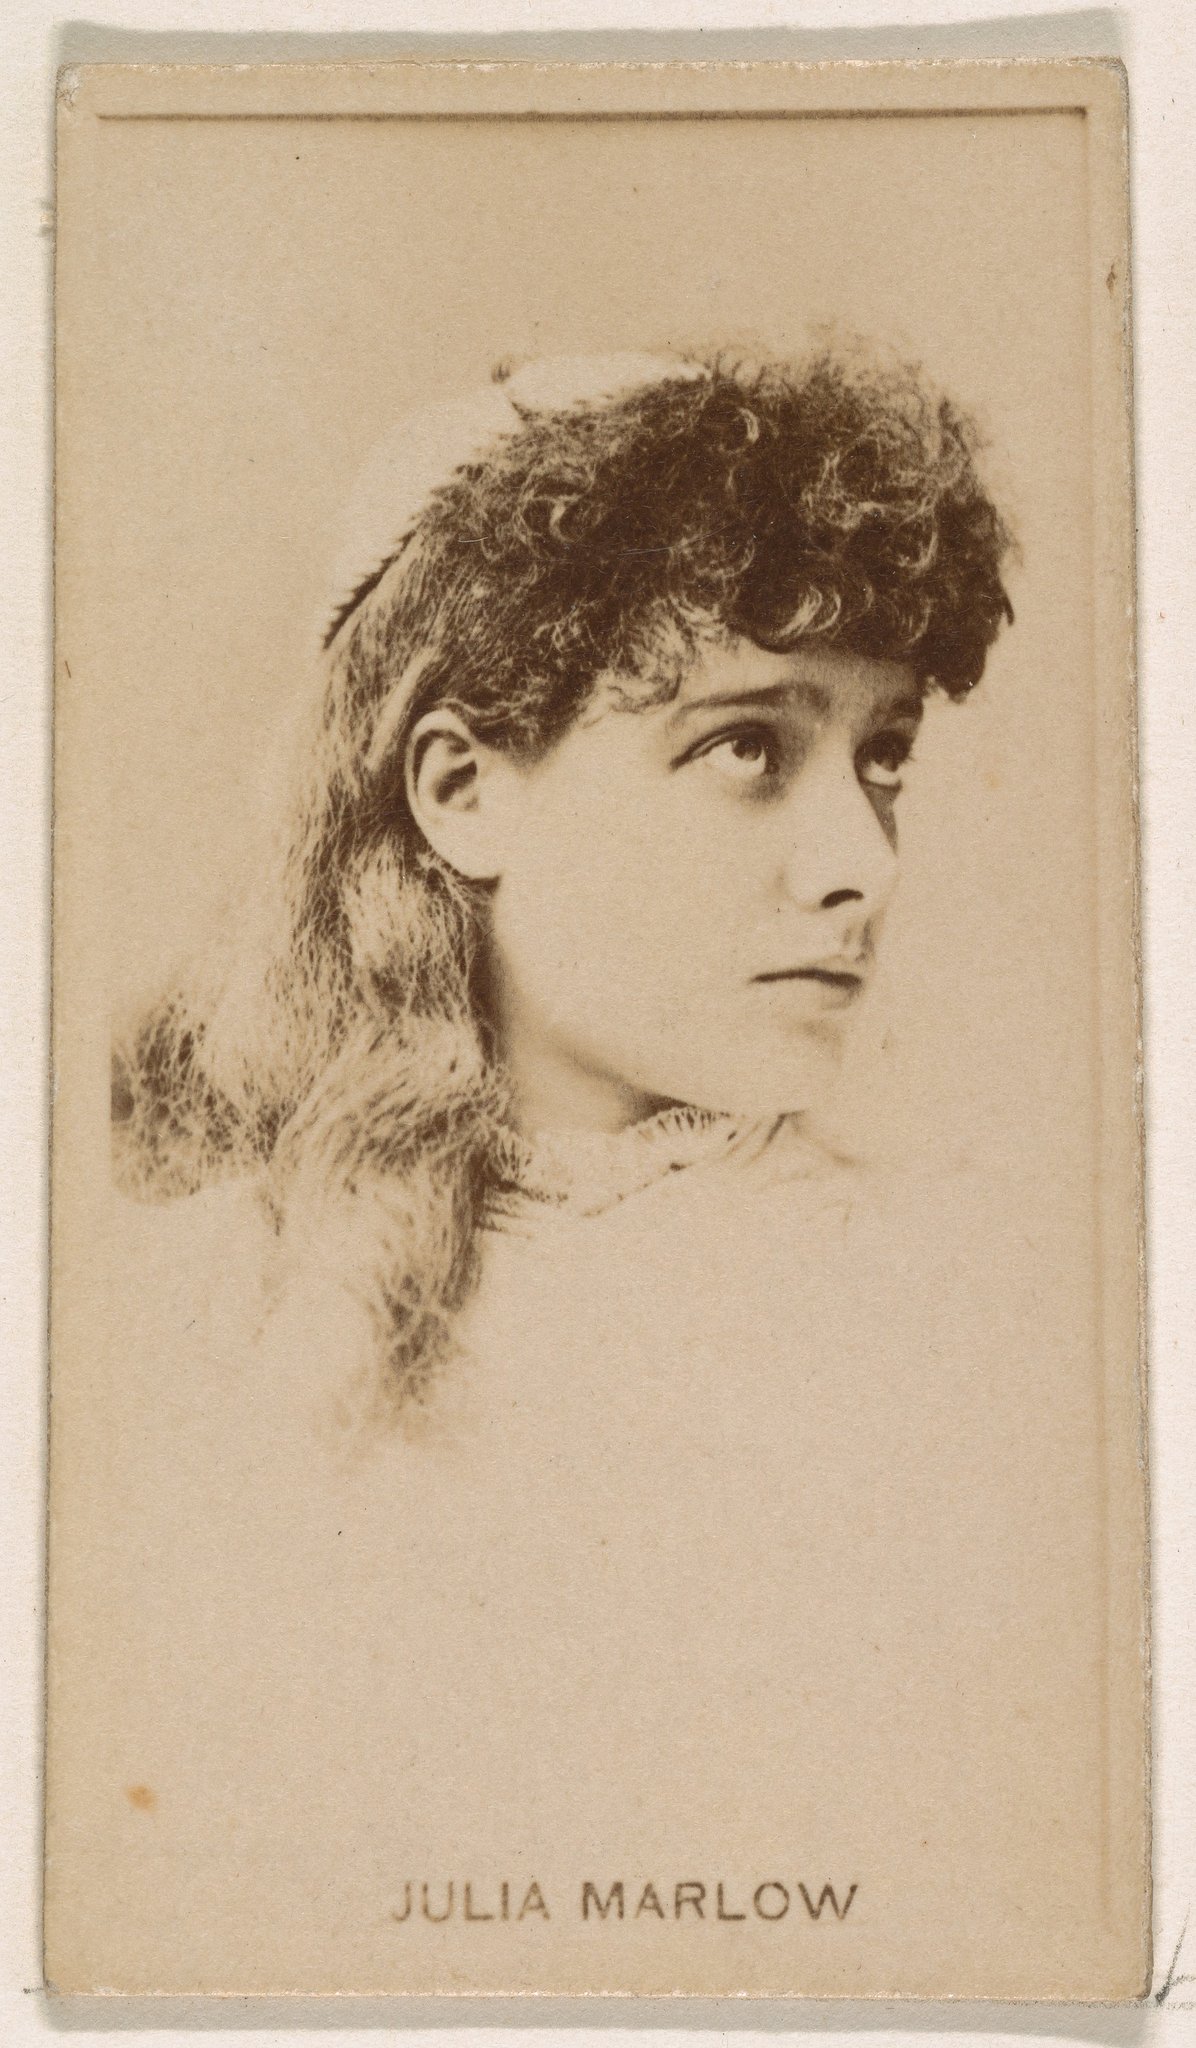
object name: photograph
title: Julia Marlow, from the Actresses series (N245) issued by Kinney Brothers to promote Sweet Caporal Cigarettes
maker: kinney brothers tobacco company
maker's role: publisher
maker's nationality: american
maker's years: 1869-2011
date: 1890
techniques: albumen silver print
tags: portraits,women,actresses